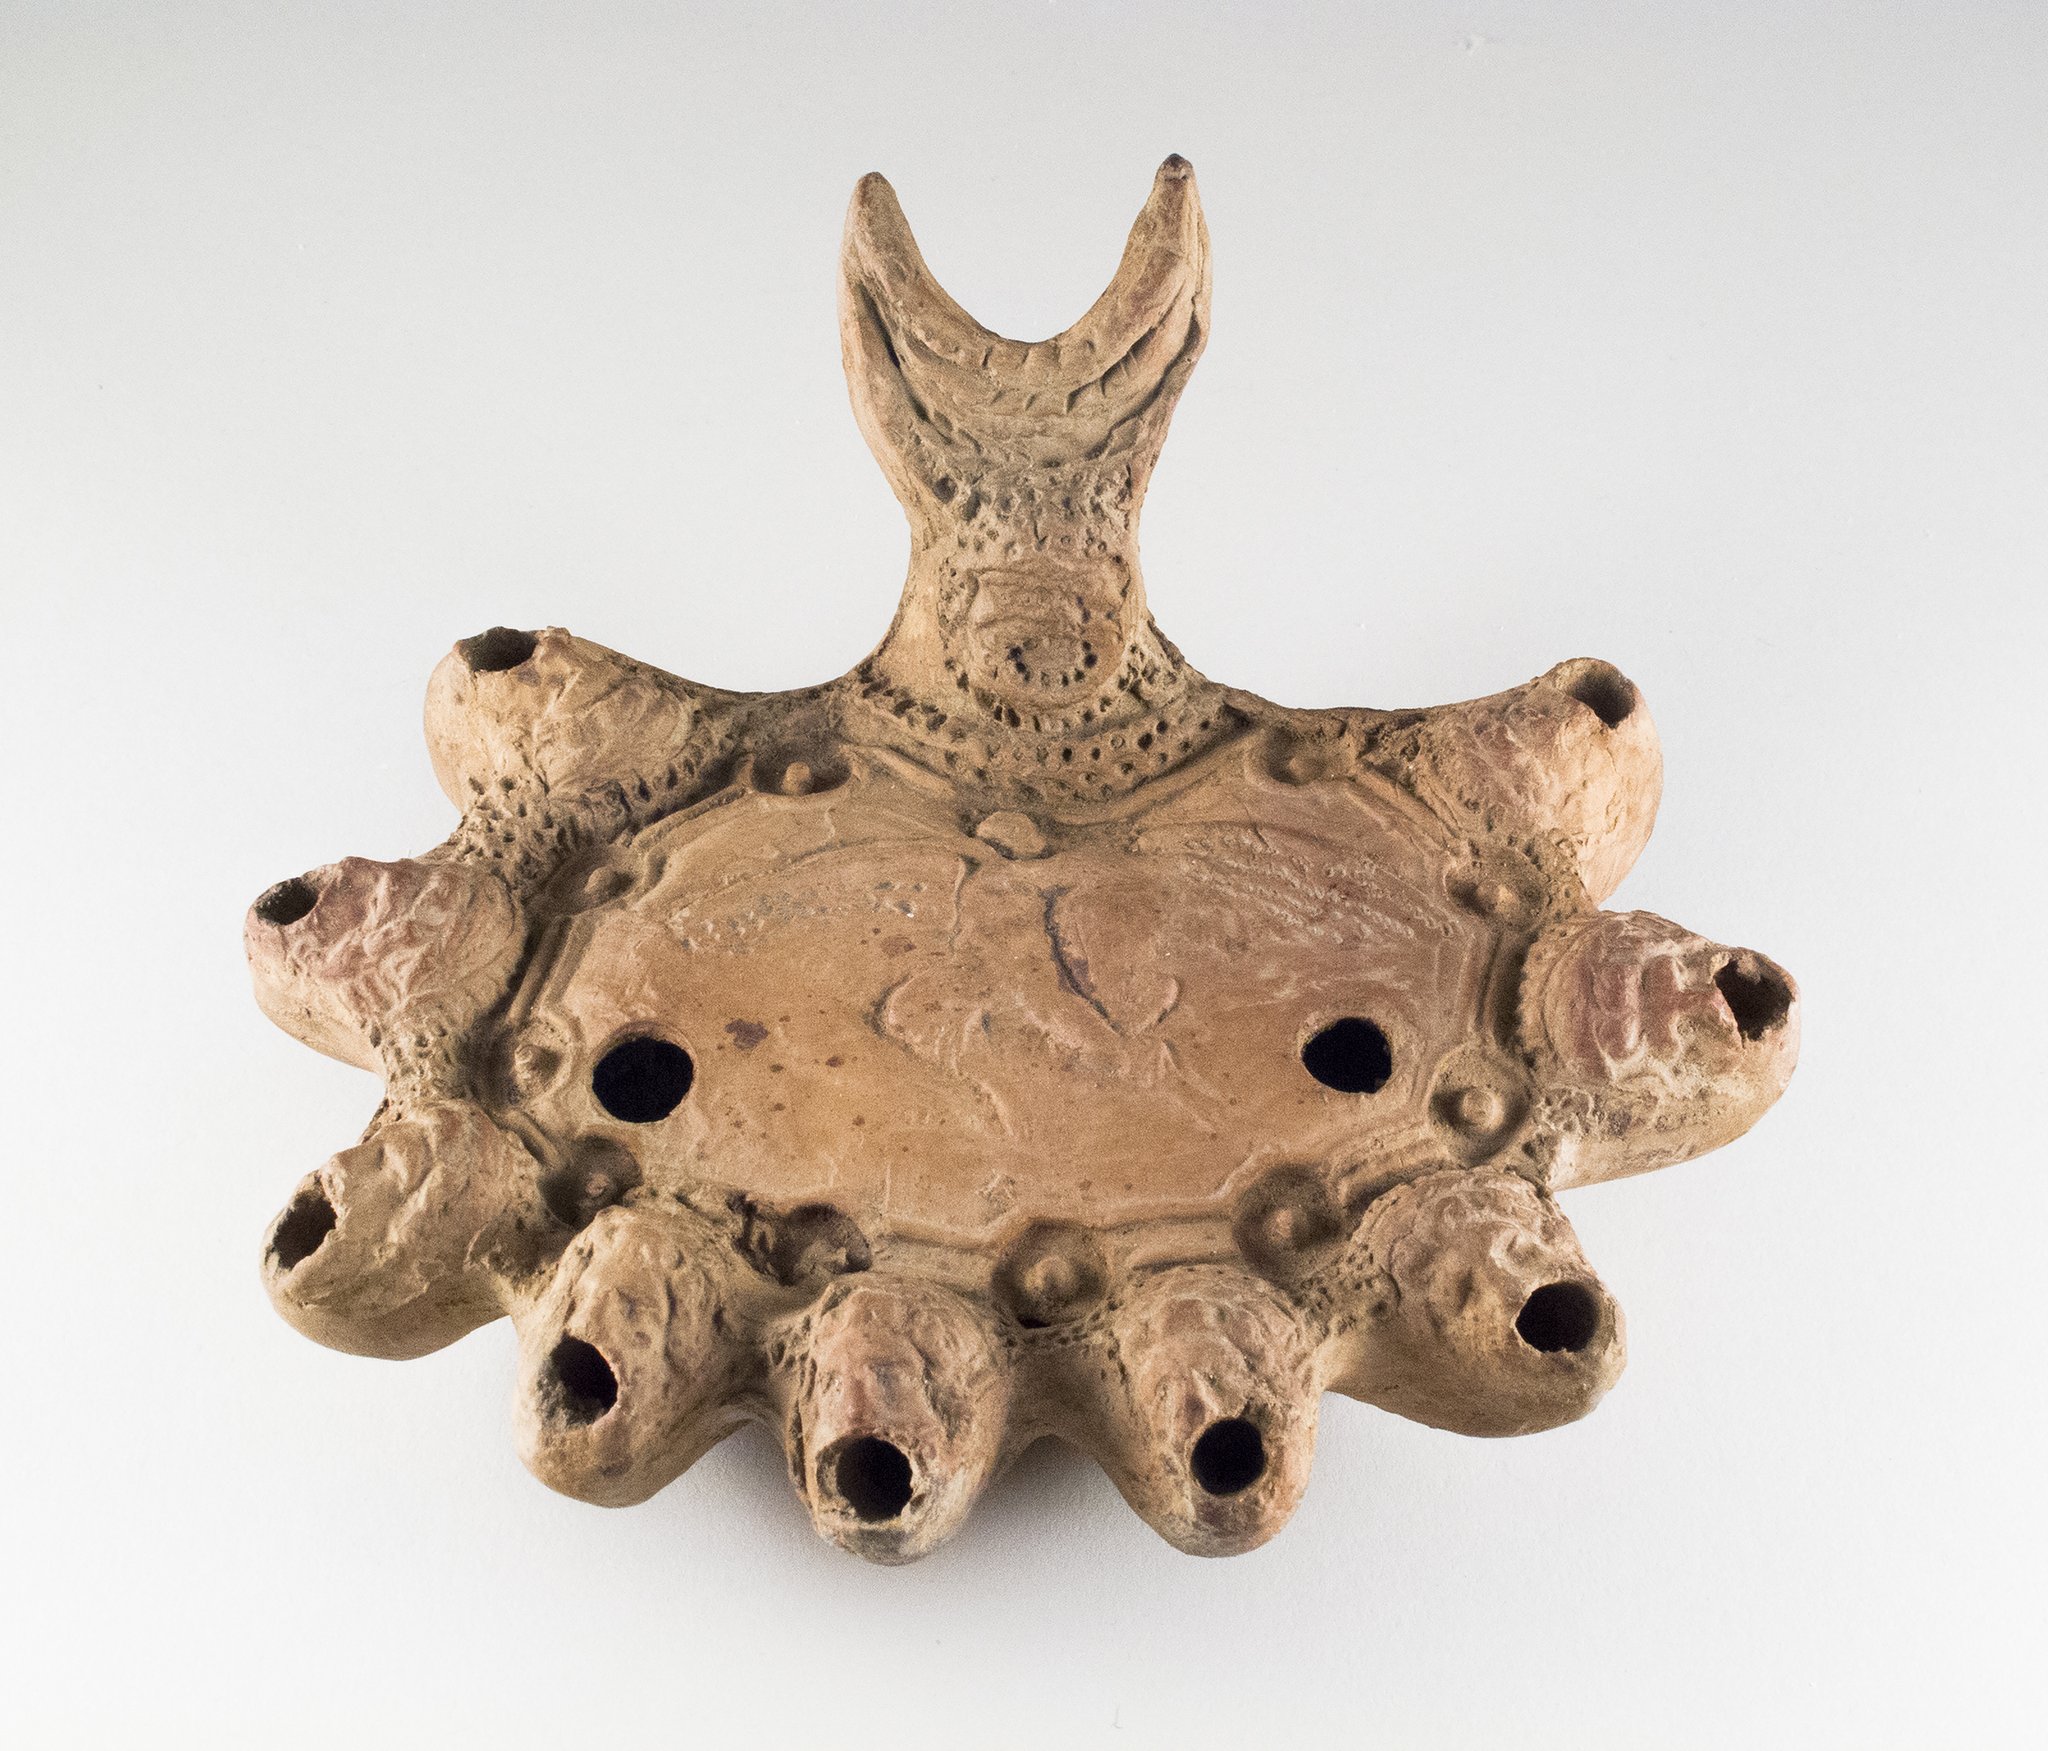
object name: lamp with nine nozzle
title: Lamp with nine nozzles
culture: roman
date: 101-200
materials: terracotta